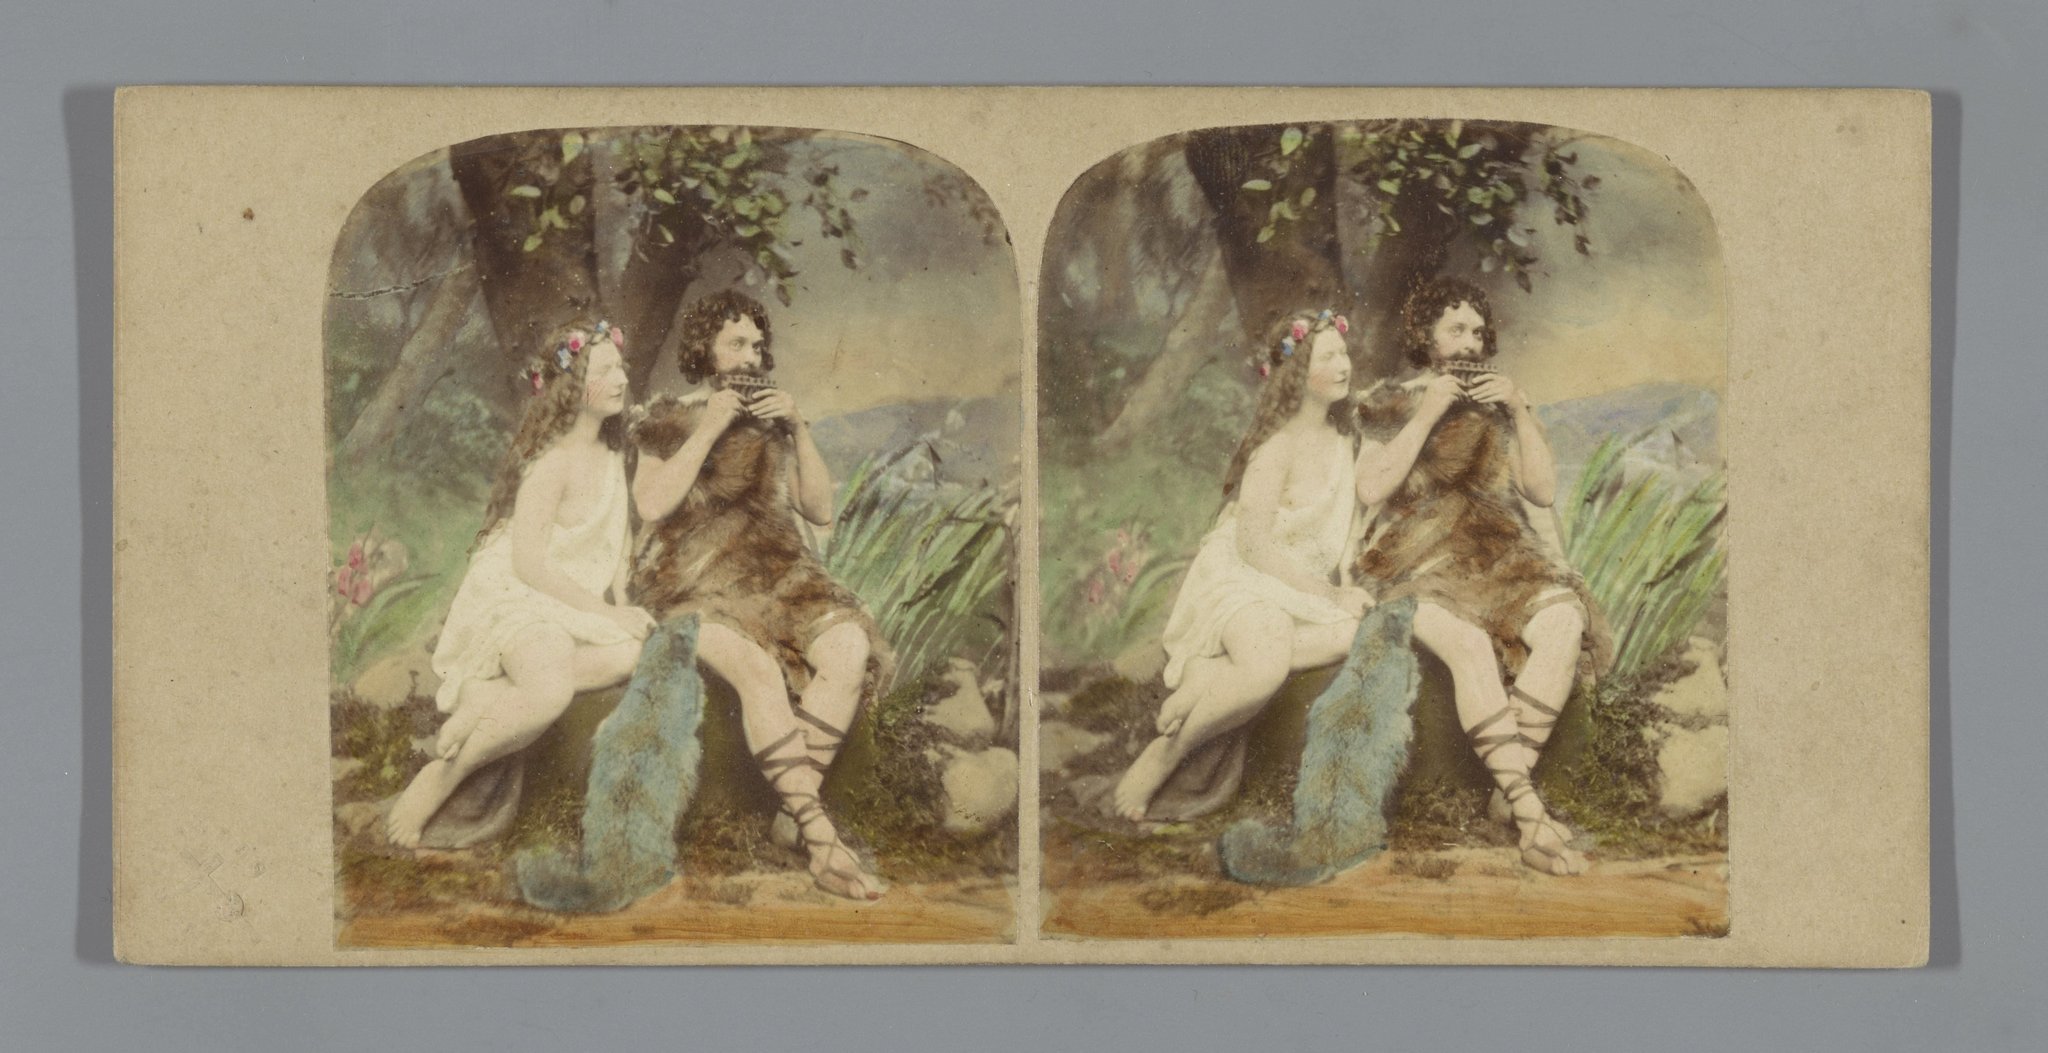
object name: stereograph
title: The Origin of Music / L'Origine de la Musique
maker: john reynolds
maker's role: fotograaf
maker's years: 1814-1871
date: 1856-1857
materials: cardboard, paper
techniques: albumen print, hand coloring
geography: london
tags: panpipes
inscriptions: inscription: ‘Entered at Stationers' Hall.’, inscription: ‘f125’